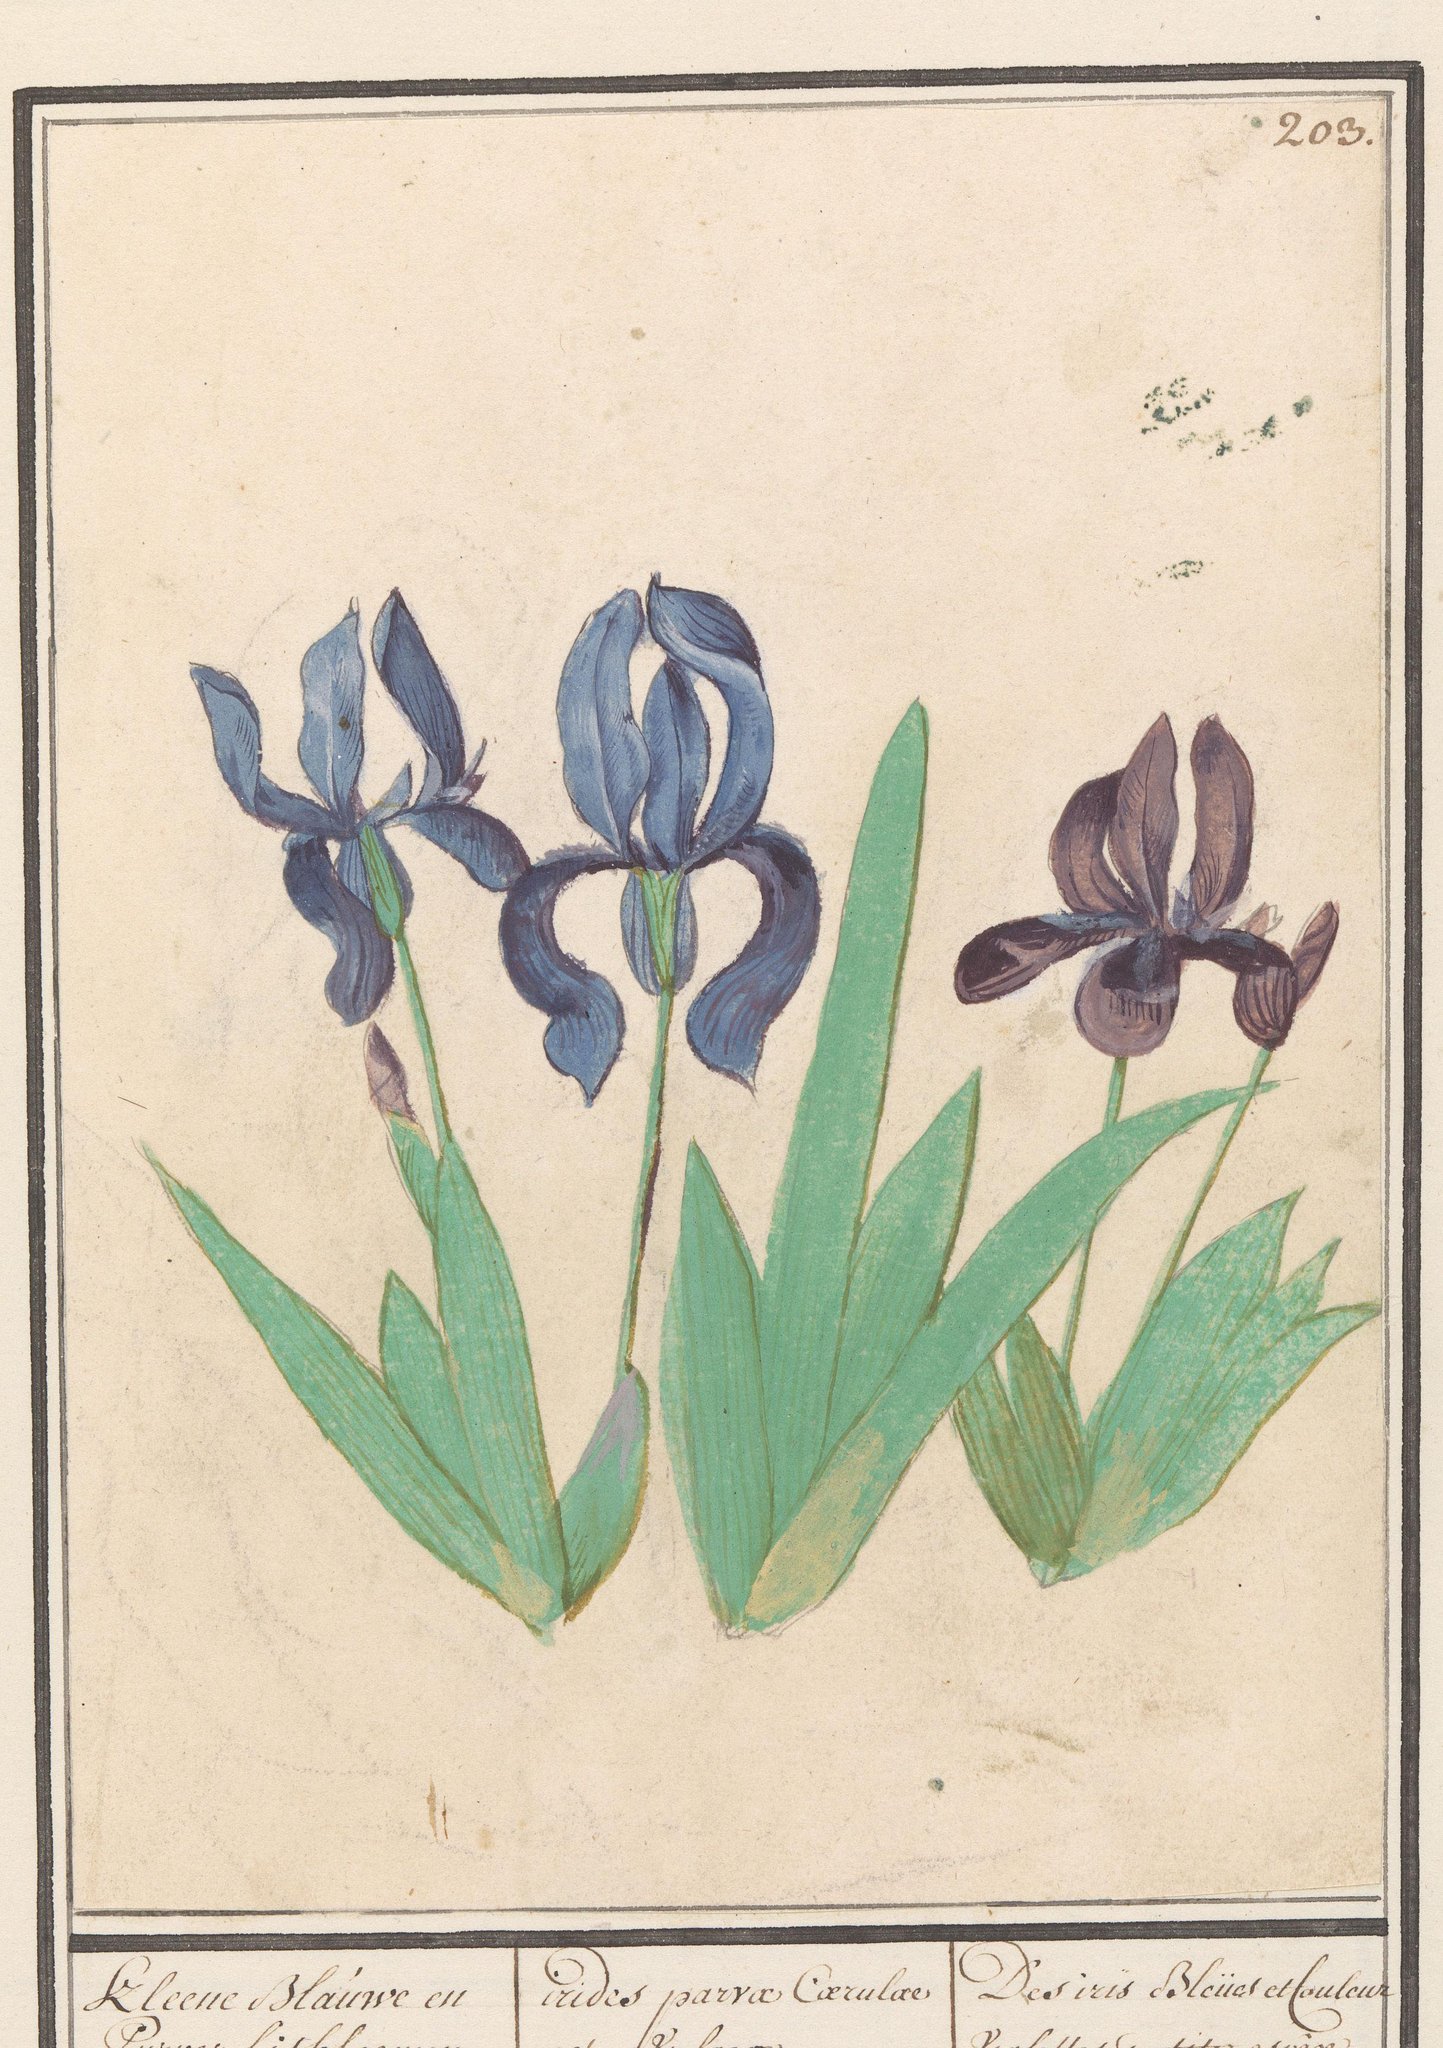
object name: drawing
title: Kleene Blauwe en Puper lisbloemen / irides parvae Coerulae et Violacae. / Des iris Bleu et Couleur Violettes petite espêce.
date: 1596-1610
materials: chalk, paint, paper, watercolor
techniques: brush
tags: flowers: iris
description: Drie blauwe en paarse irissen. Genummerd rechtsboven: 203. Onderdeel van het derde album met tekeningen van bloemen en planten. Tiende van twaalf albums met tekeningen van dieren, vogels en planten bekend rond 1600, gemaakt in opdracht van keizer Rudolf II. Met toelichting in Nederlands, Latijn en Frans.